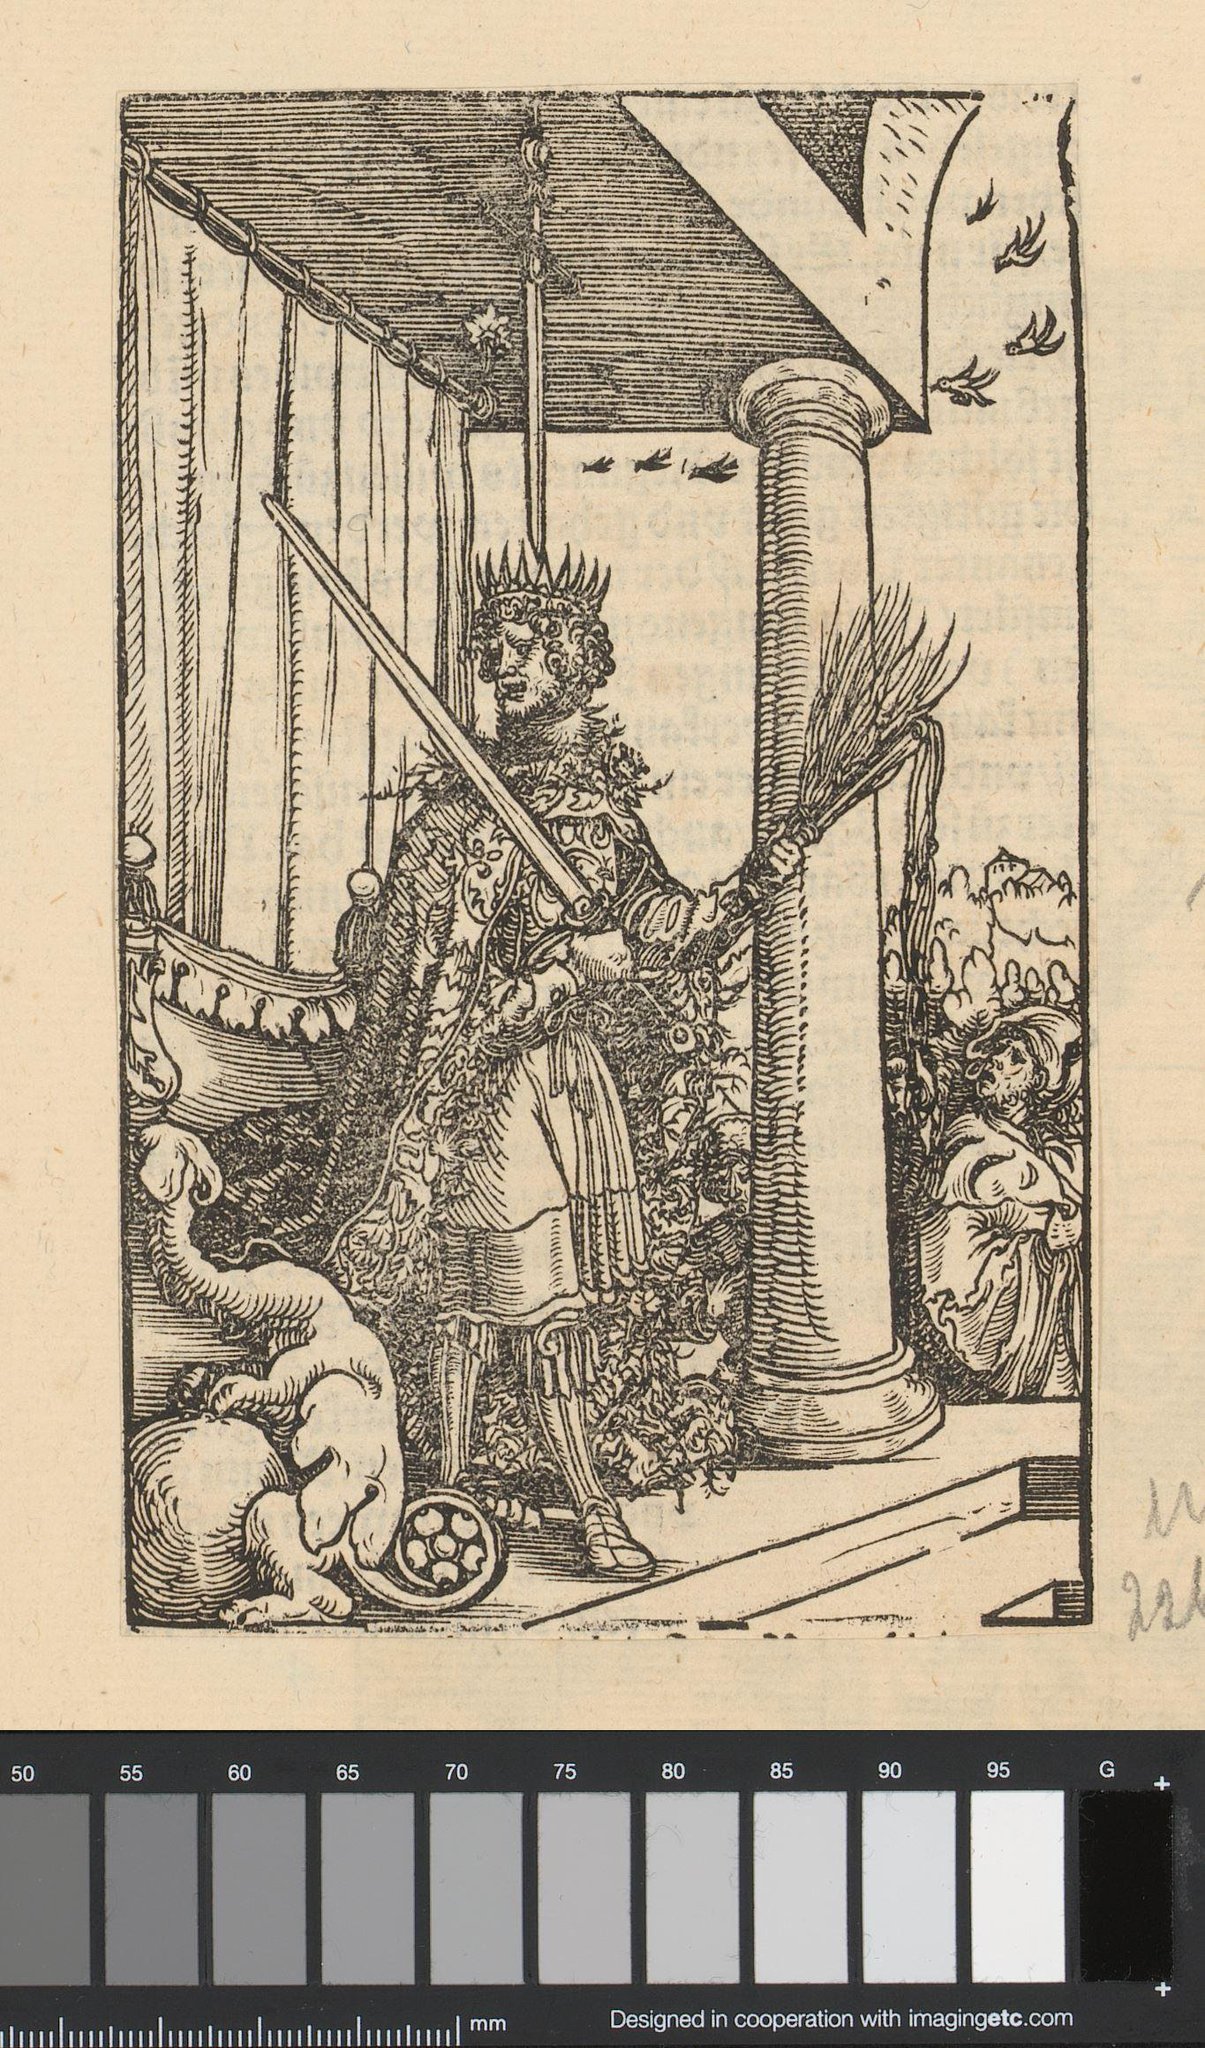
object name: album leaf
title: Heerser met roede, zweep en zwaard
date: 1514-1532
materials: paper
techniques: letterpress printing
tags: hacking and thrusting weapons: sword, ruler, sovereign, instruments of torture, execution or punishment: scourge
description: Deze prent is gebruikt in: Petrarca, Francesco. Von der Artzney bayder Glück, des guten und widerwertigen: unnd weß sich ain yeder inn Gelück und Unglück halten sol (...). Augsburg: Heinrich Steiner, 1532. Deze uitgave is ook bekend onder de titel 'Trostspiegel in Glück und Unglück'. Deze prent is ook gebruikt in: Cicero, Marcus Tulius. Officia M.T.C. Ein Buch so Marcus Tullius Cicero der Römer zu seynem (...). [Vertaald uit het Latijn door] Johann von Schwarzenberg. Augsburg: Heinrich Steiner, 1531.